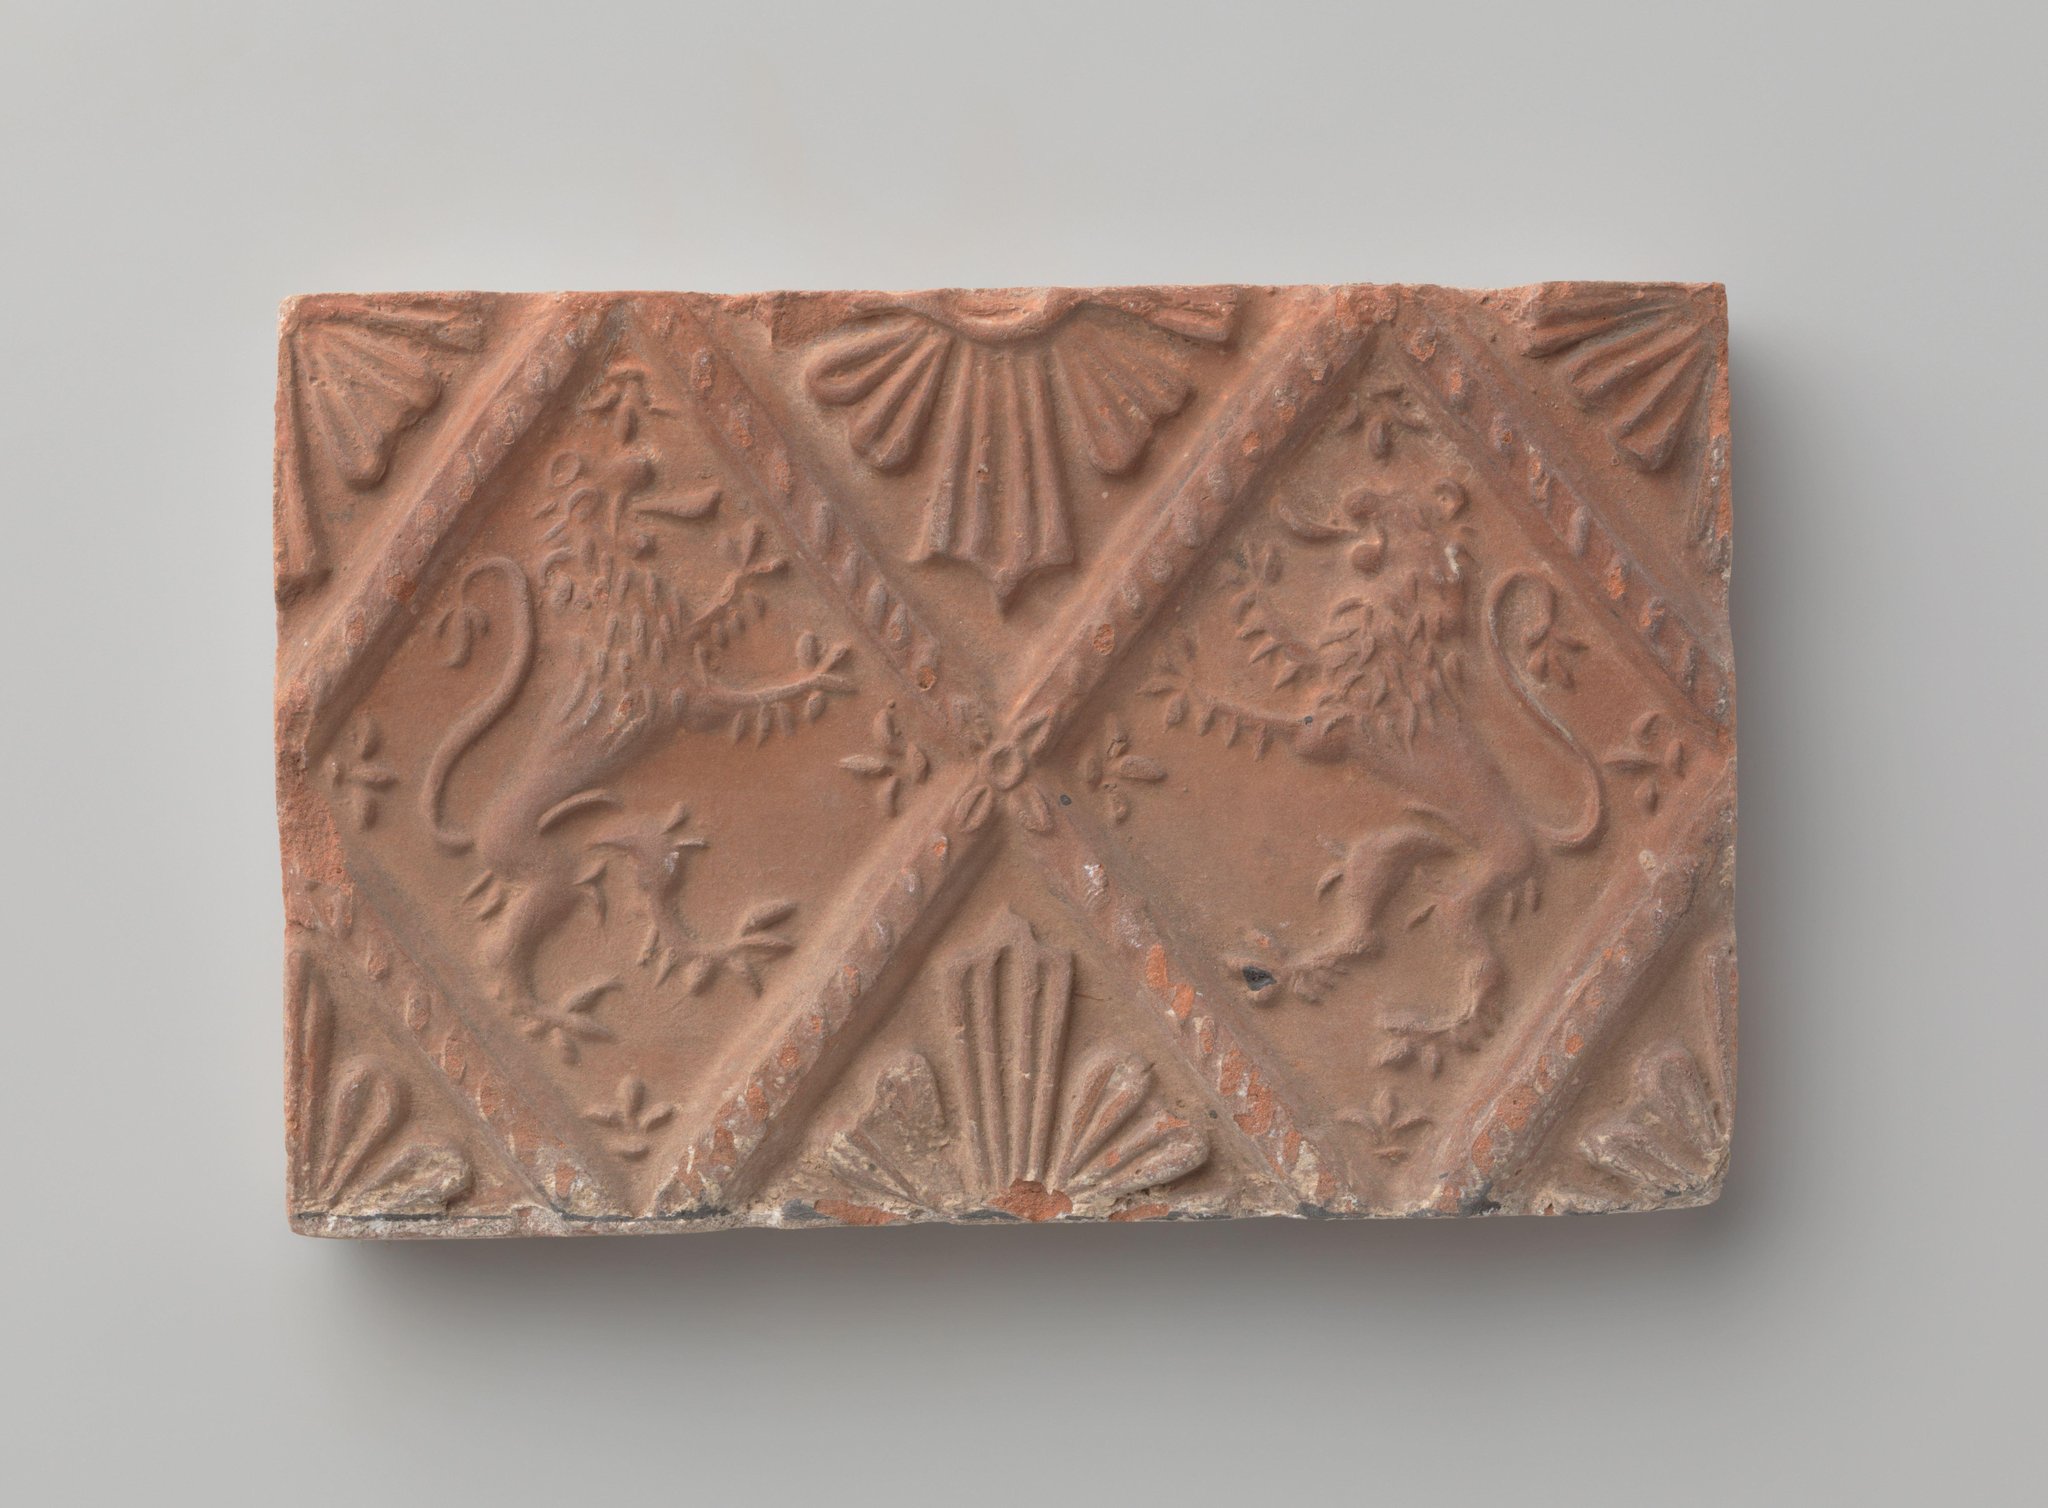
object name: hearthstone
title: Haardsteen met voorstelling van twee klimmende leeuwen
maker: Anonymous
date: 1875-1900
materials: earthenware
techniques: printing, firing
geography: netherlands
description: Haardsteen met voorstelling van twee klimmende leeuwen, geplaatst in geprofileerde ruit. De halve ruiten aan de boven- en onderkant zijn opgevuld met stermotief.